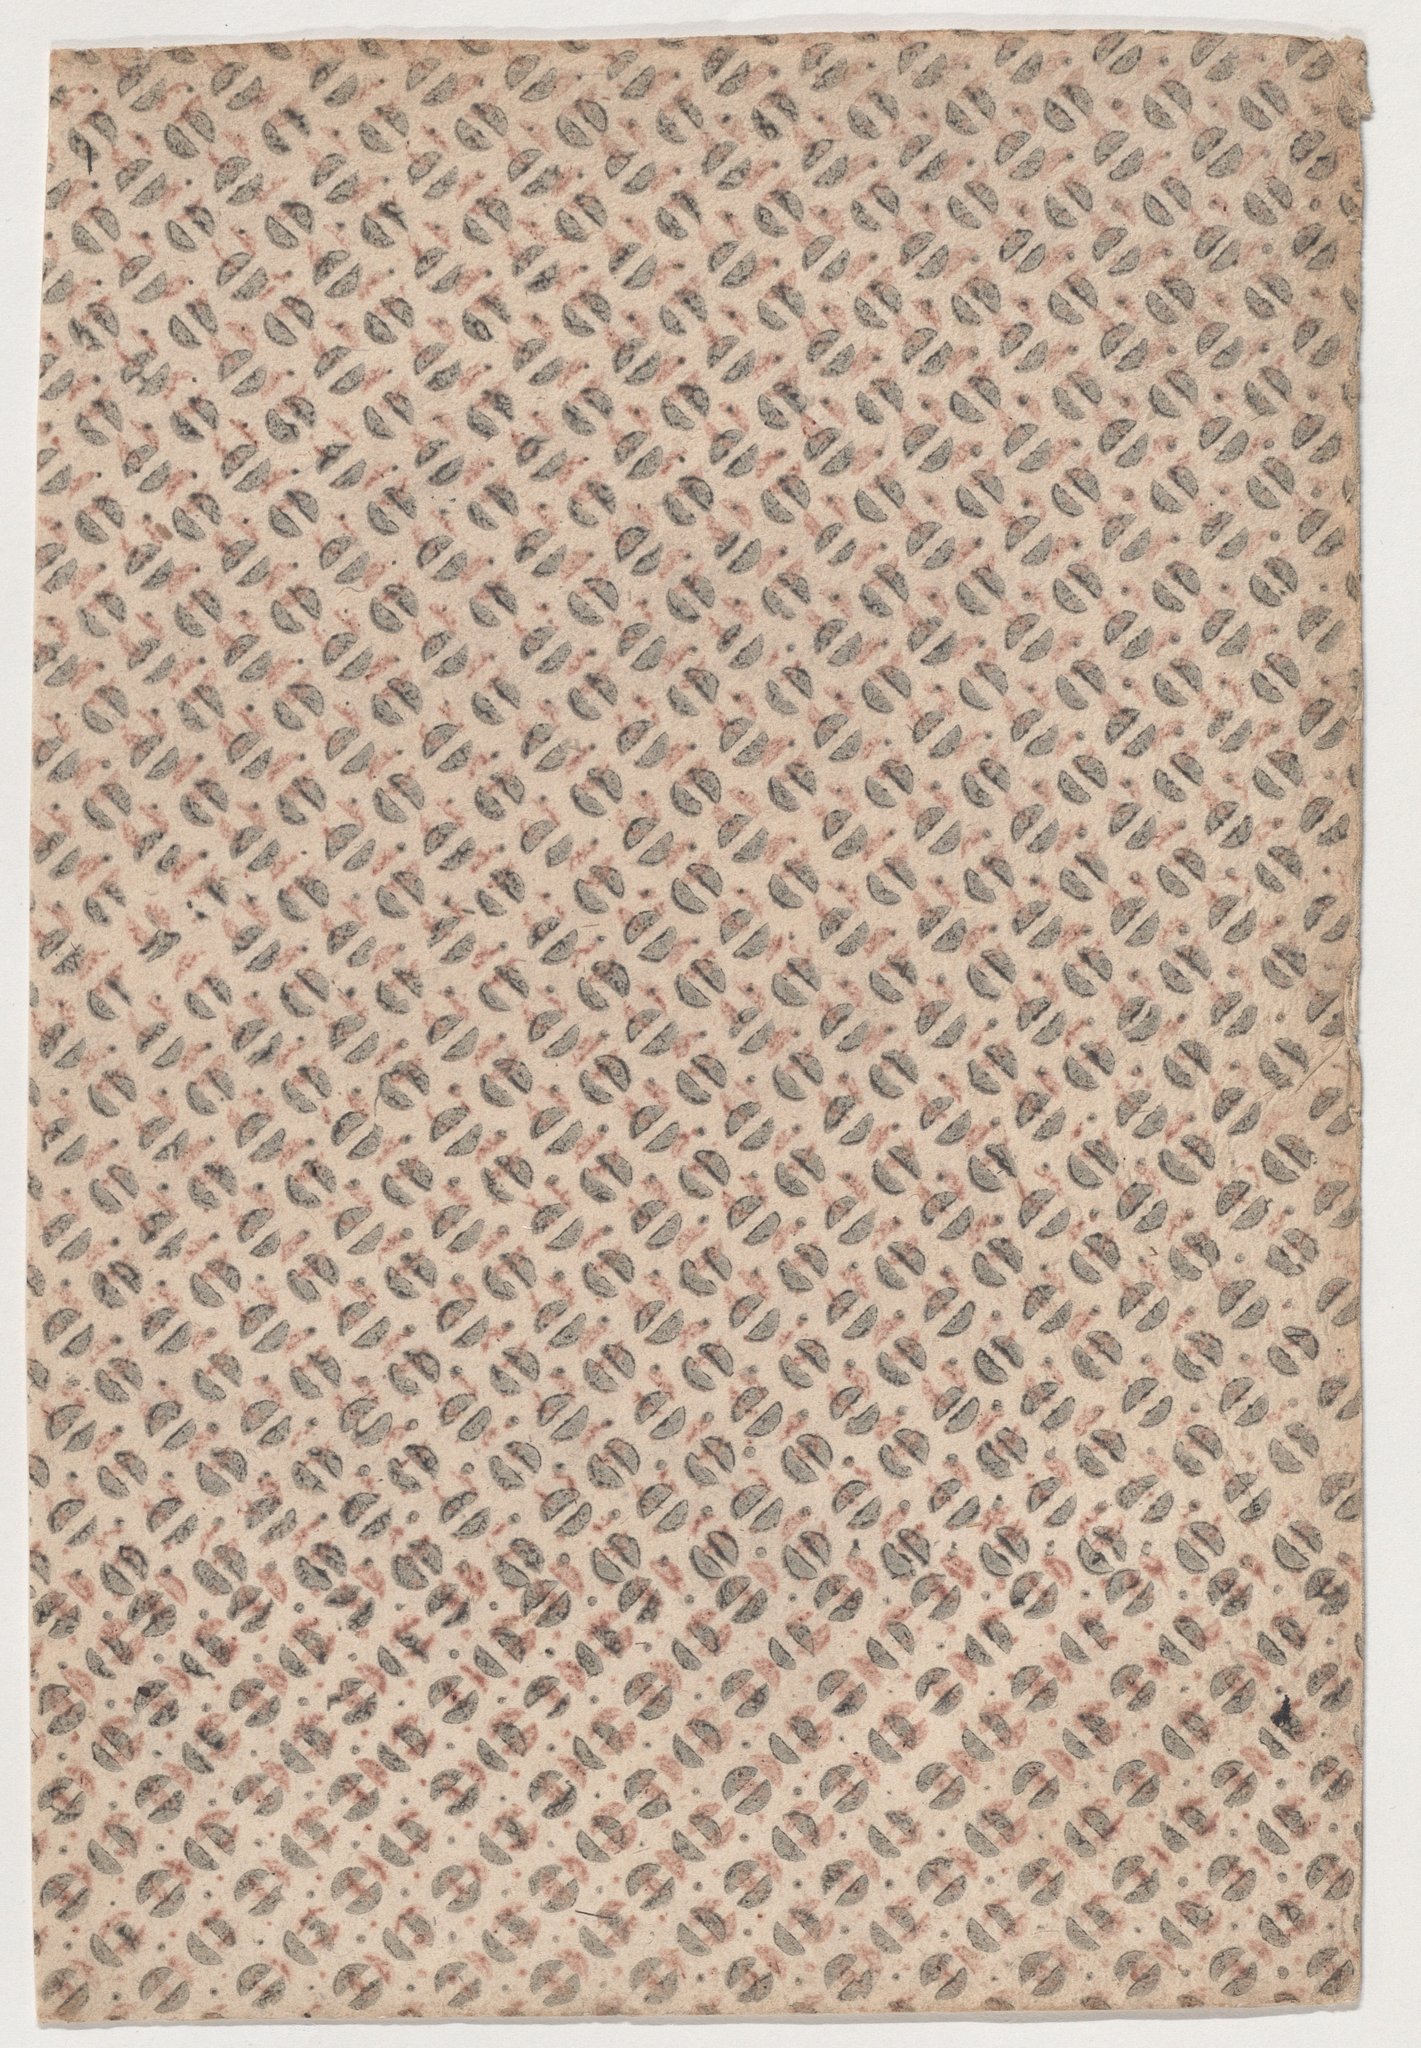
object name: print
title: Sheet with an overall pattern of semicircles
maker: Anonymous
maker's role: artist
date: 1801-1900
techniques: relief print